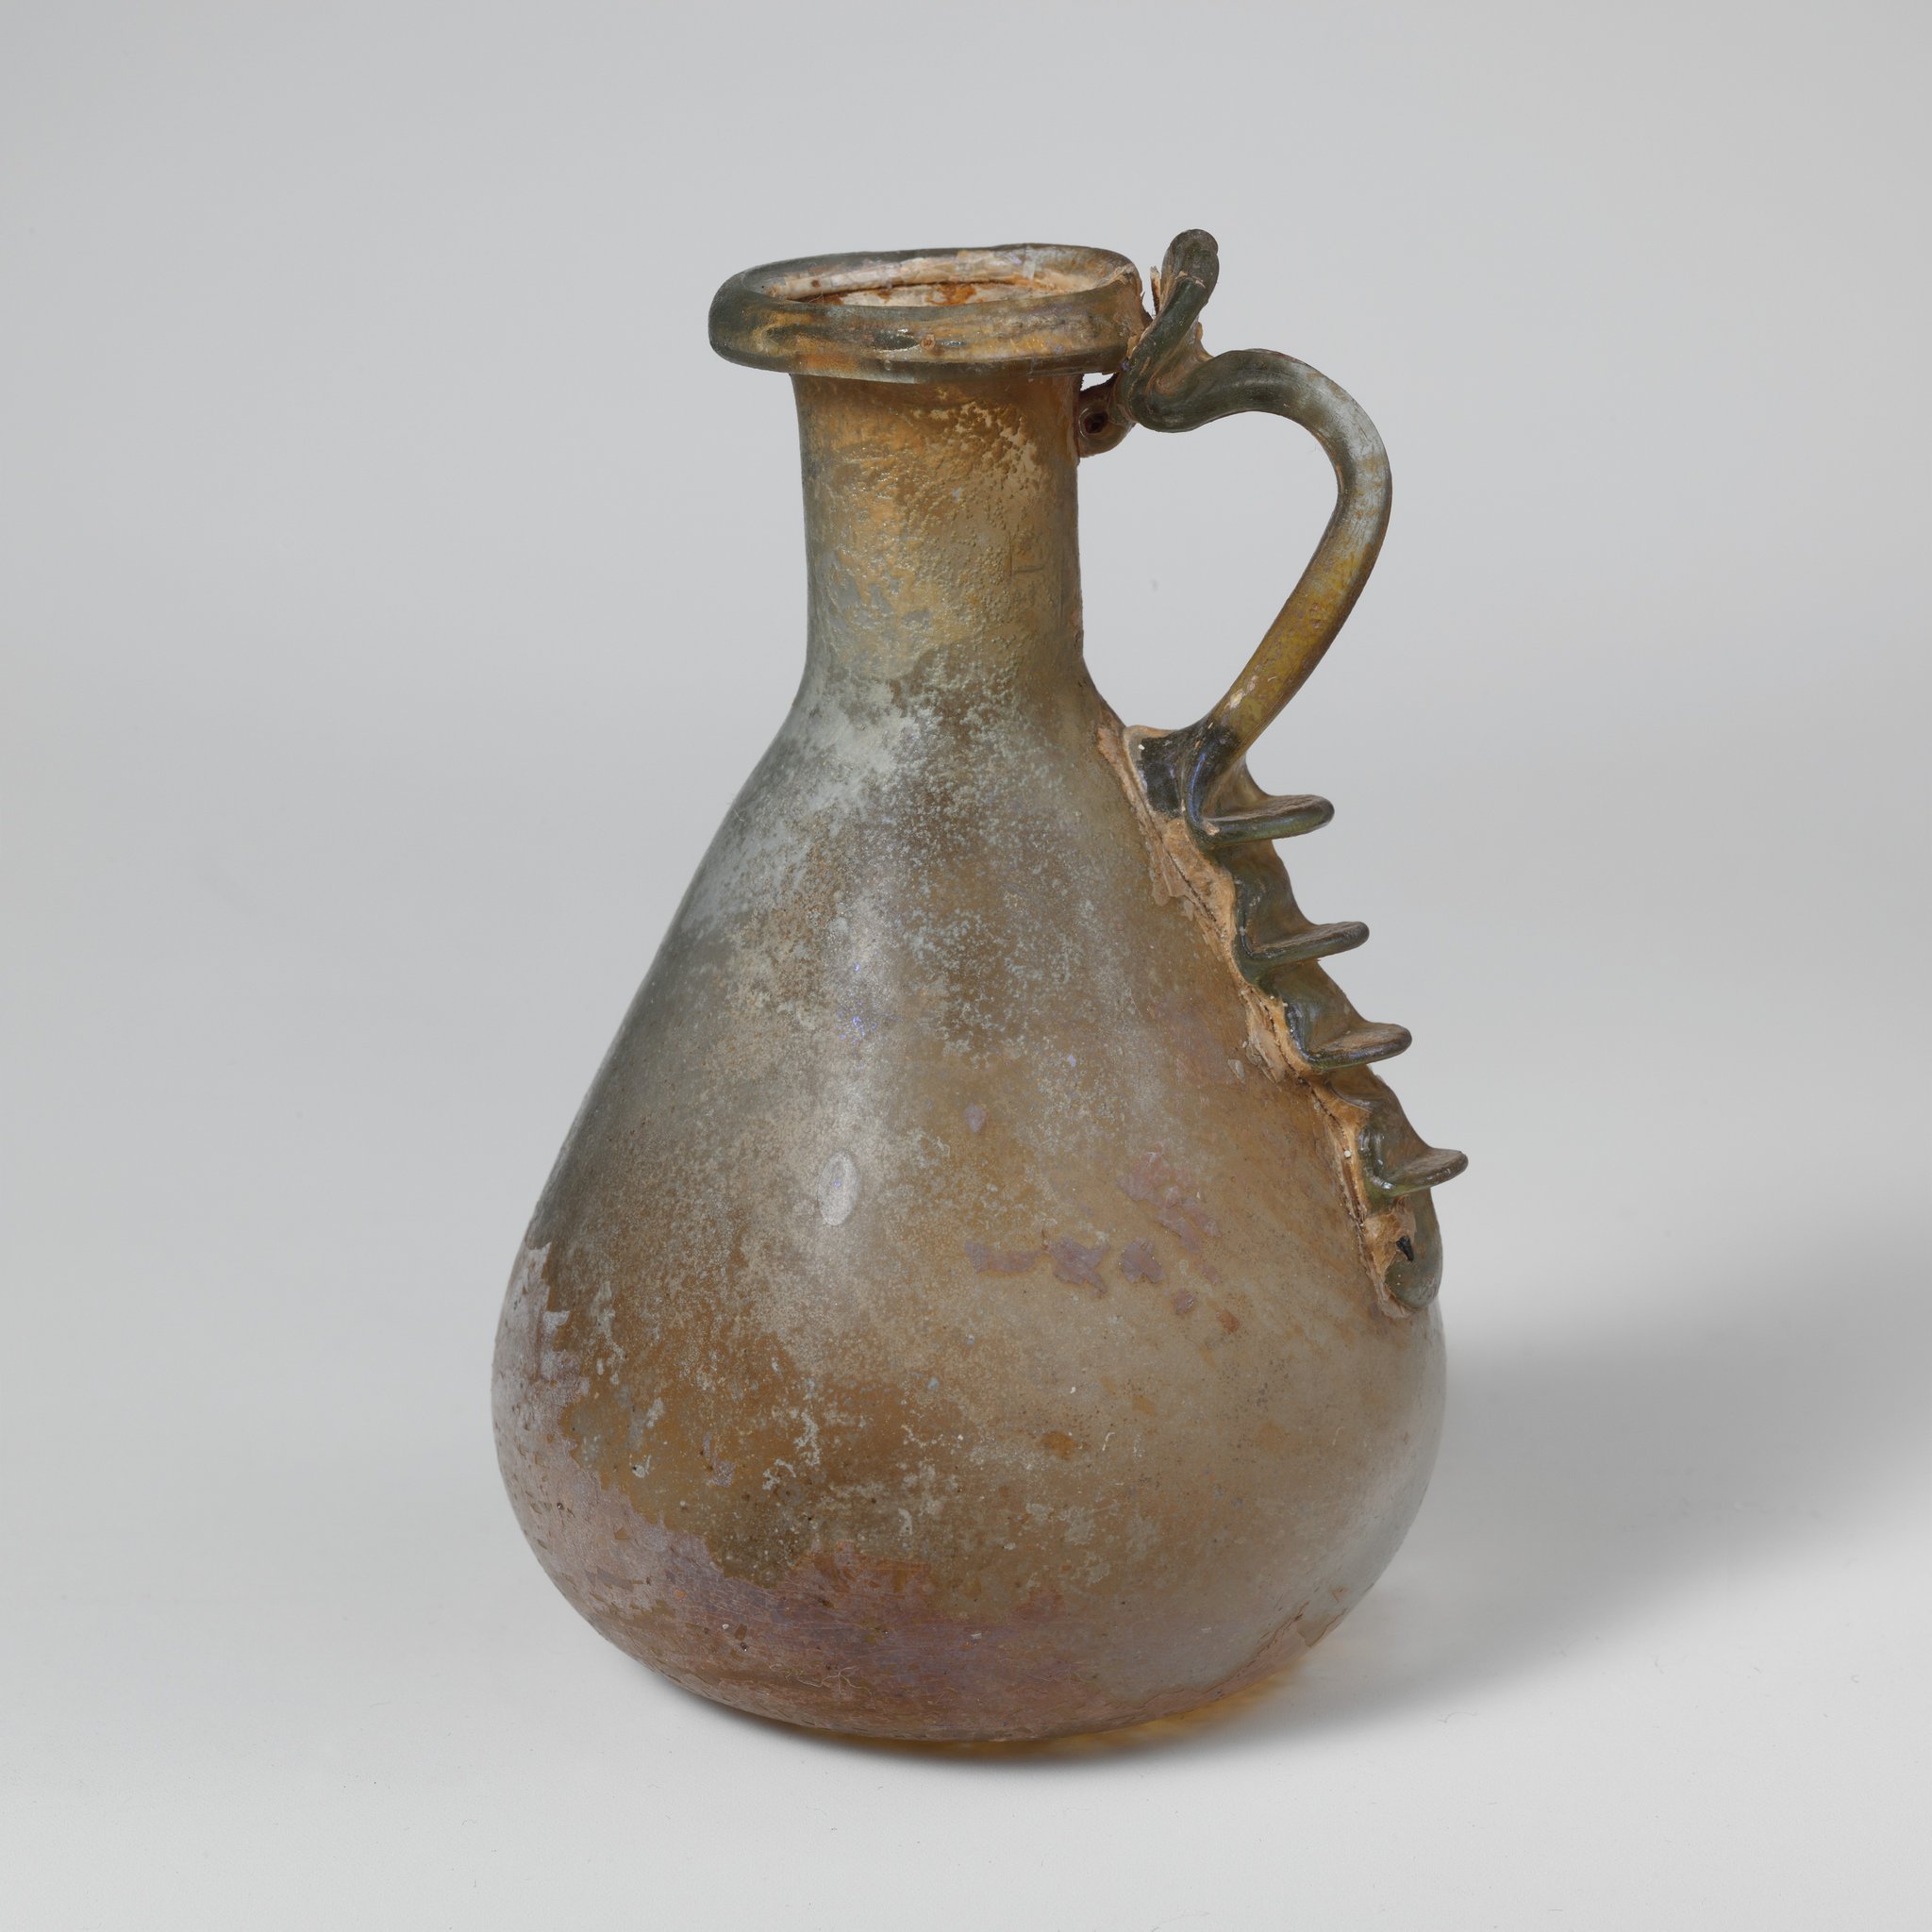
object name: jug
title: Glass jug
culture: roman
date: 1-200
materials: glass